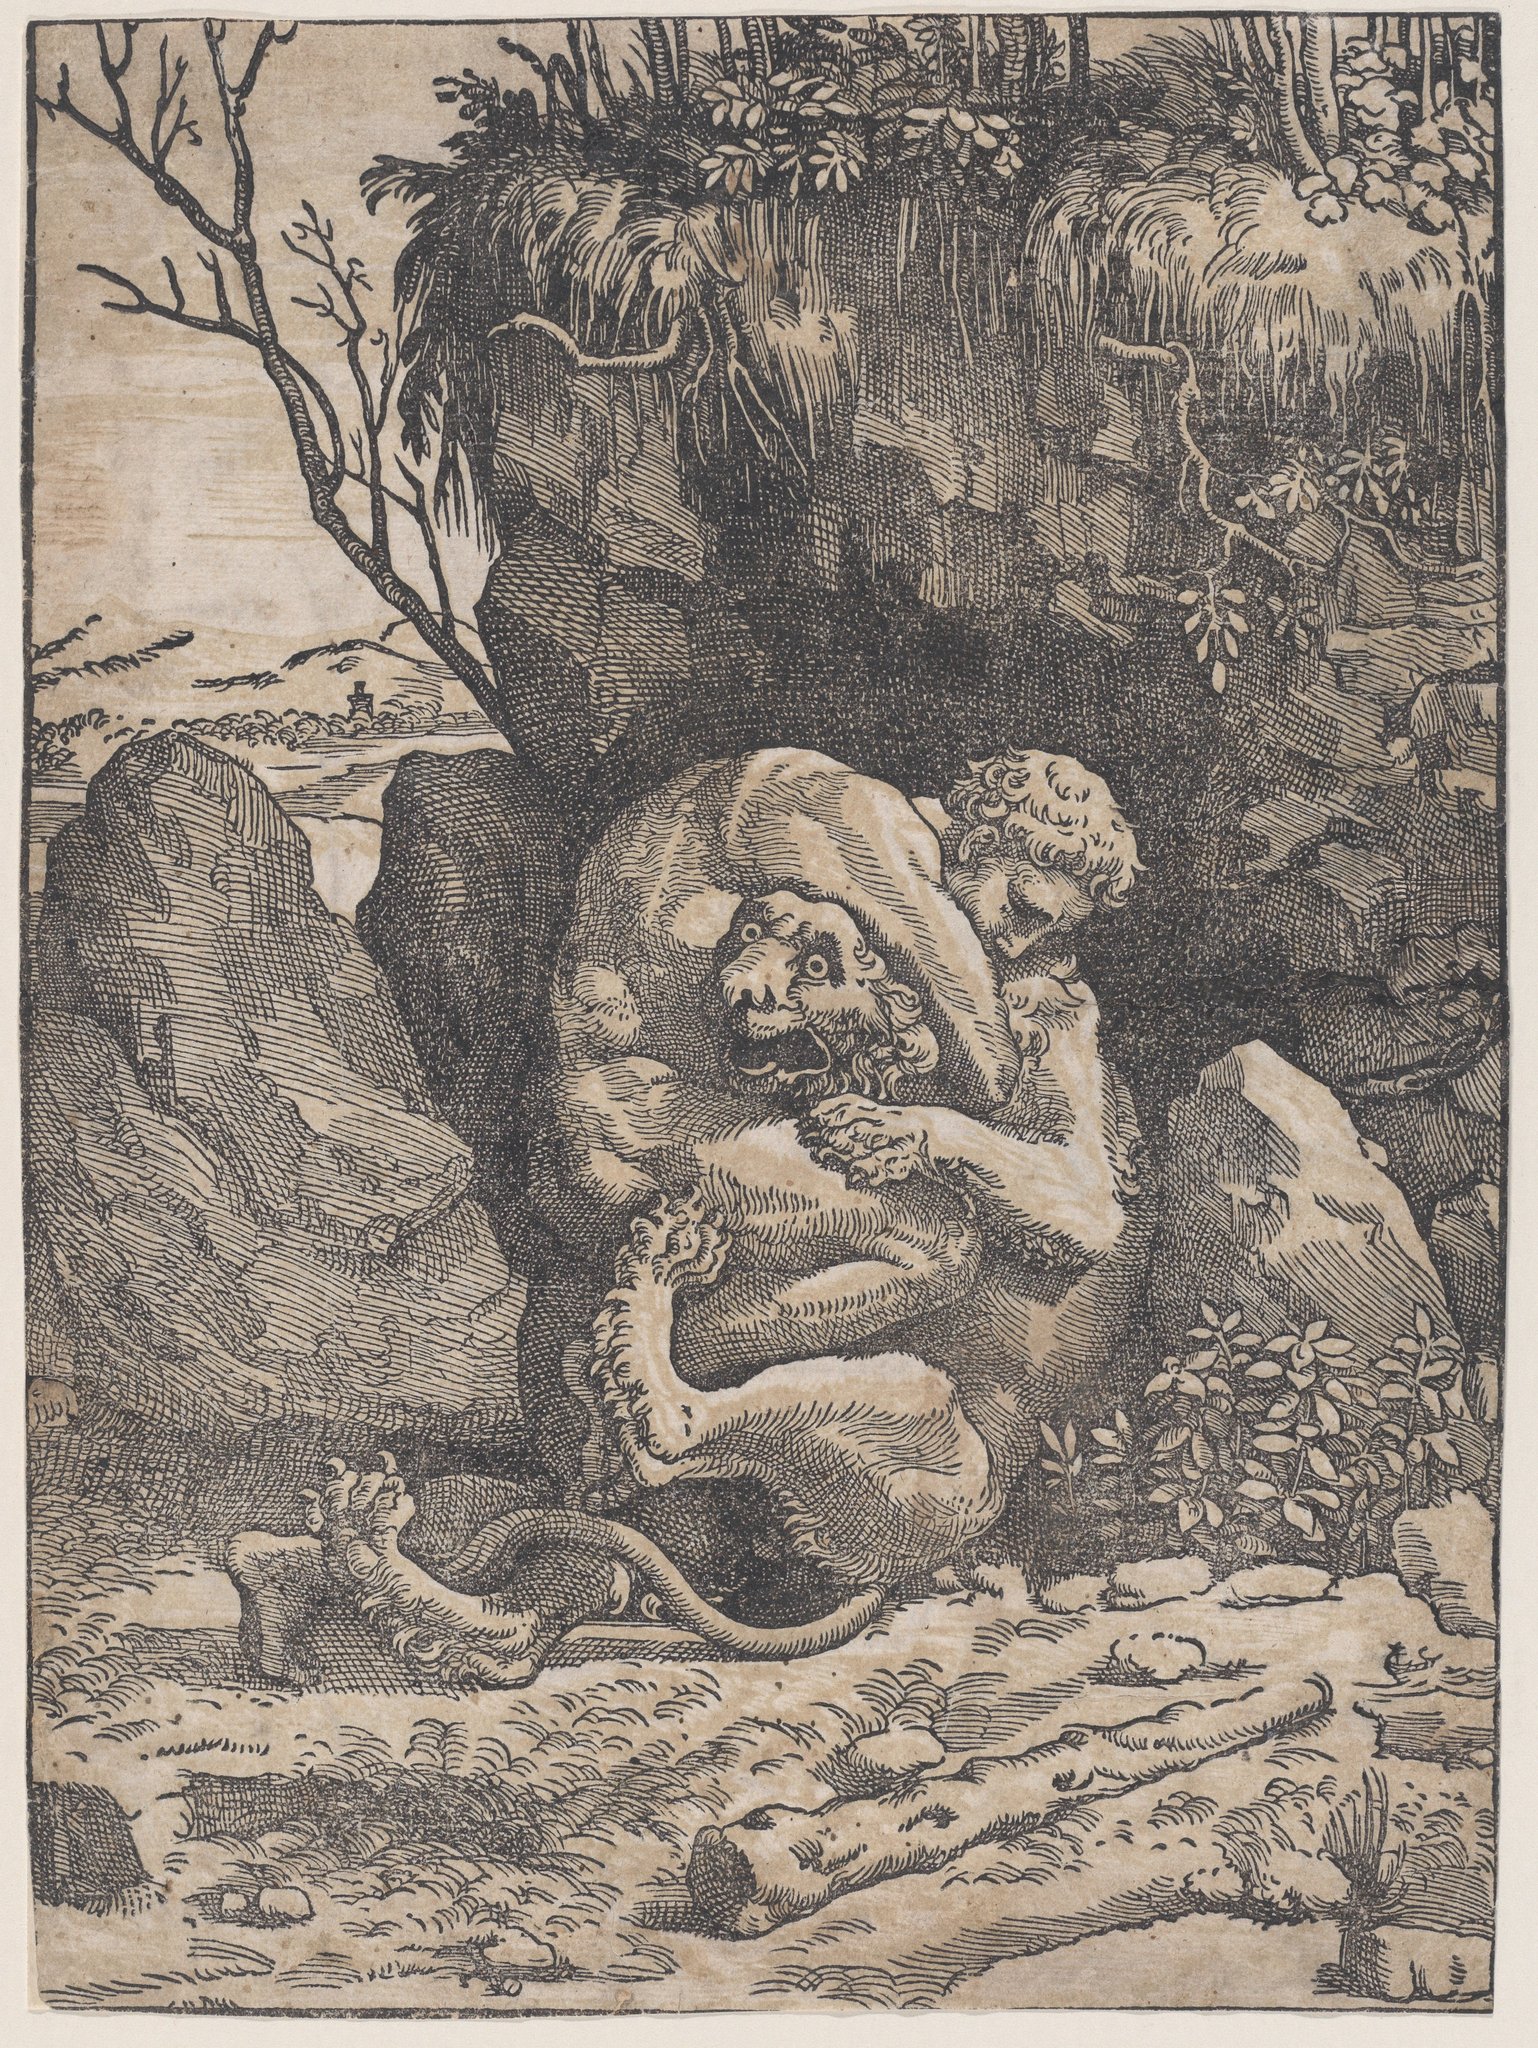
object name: print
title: Hercules and the Nemean Lion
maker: ugo da carpi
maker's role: artist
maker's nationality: italian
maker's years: 1480-1532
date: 1517-1518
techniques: woodcut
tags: male nudes,hercules,lions